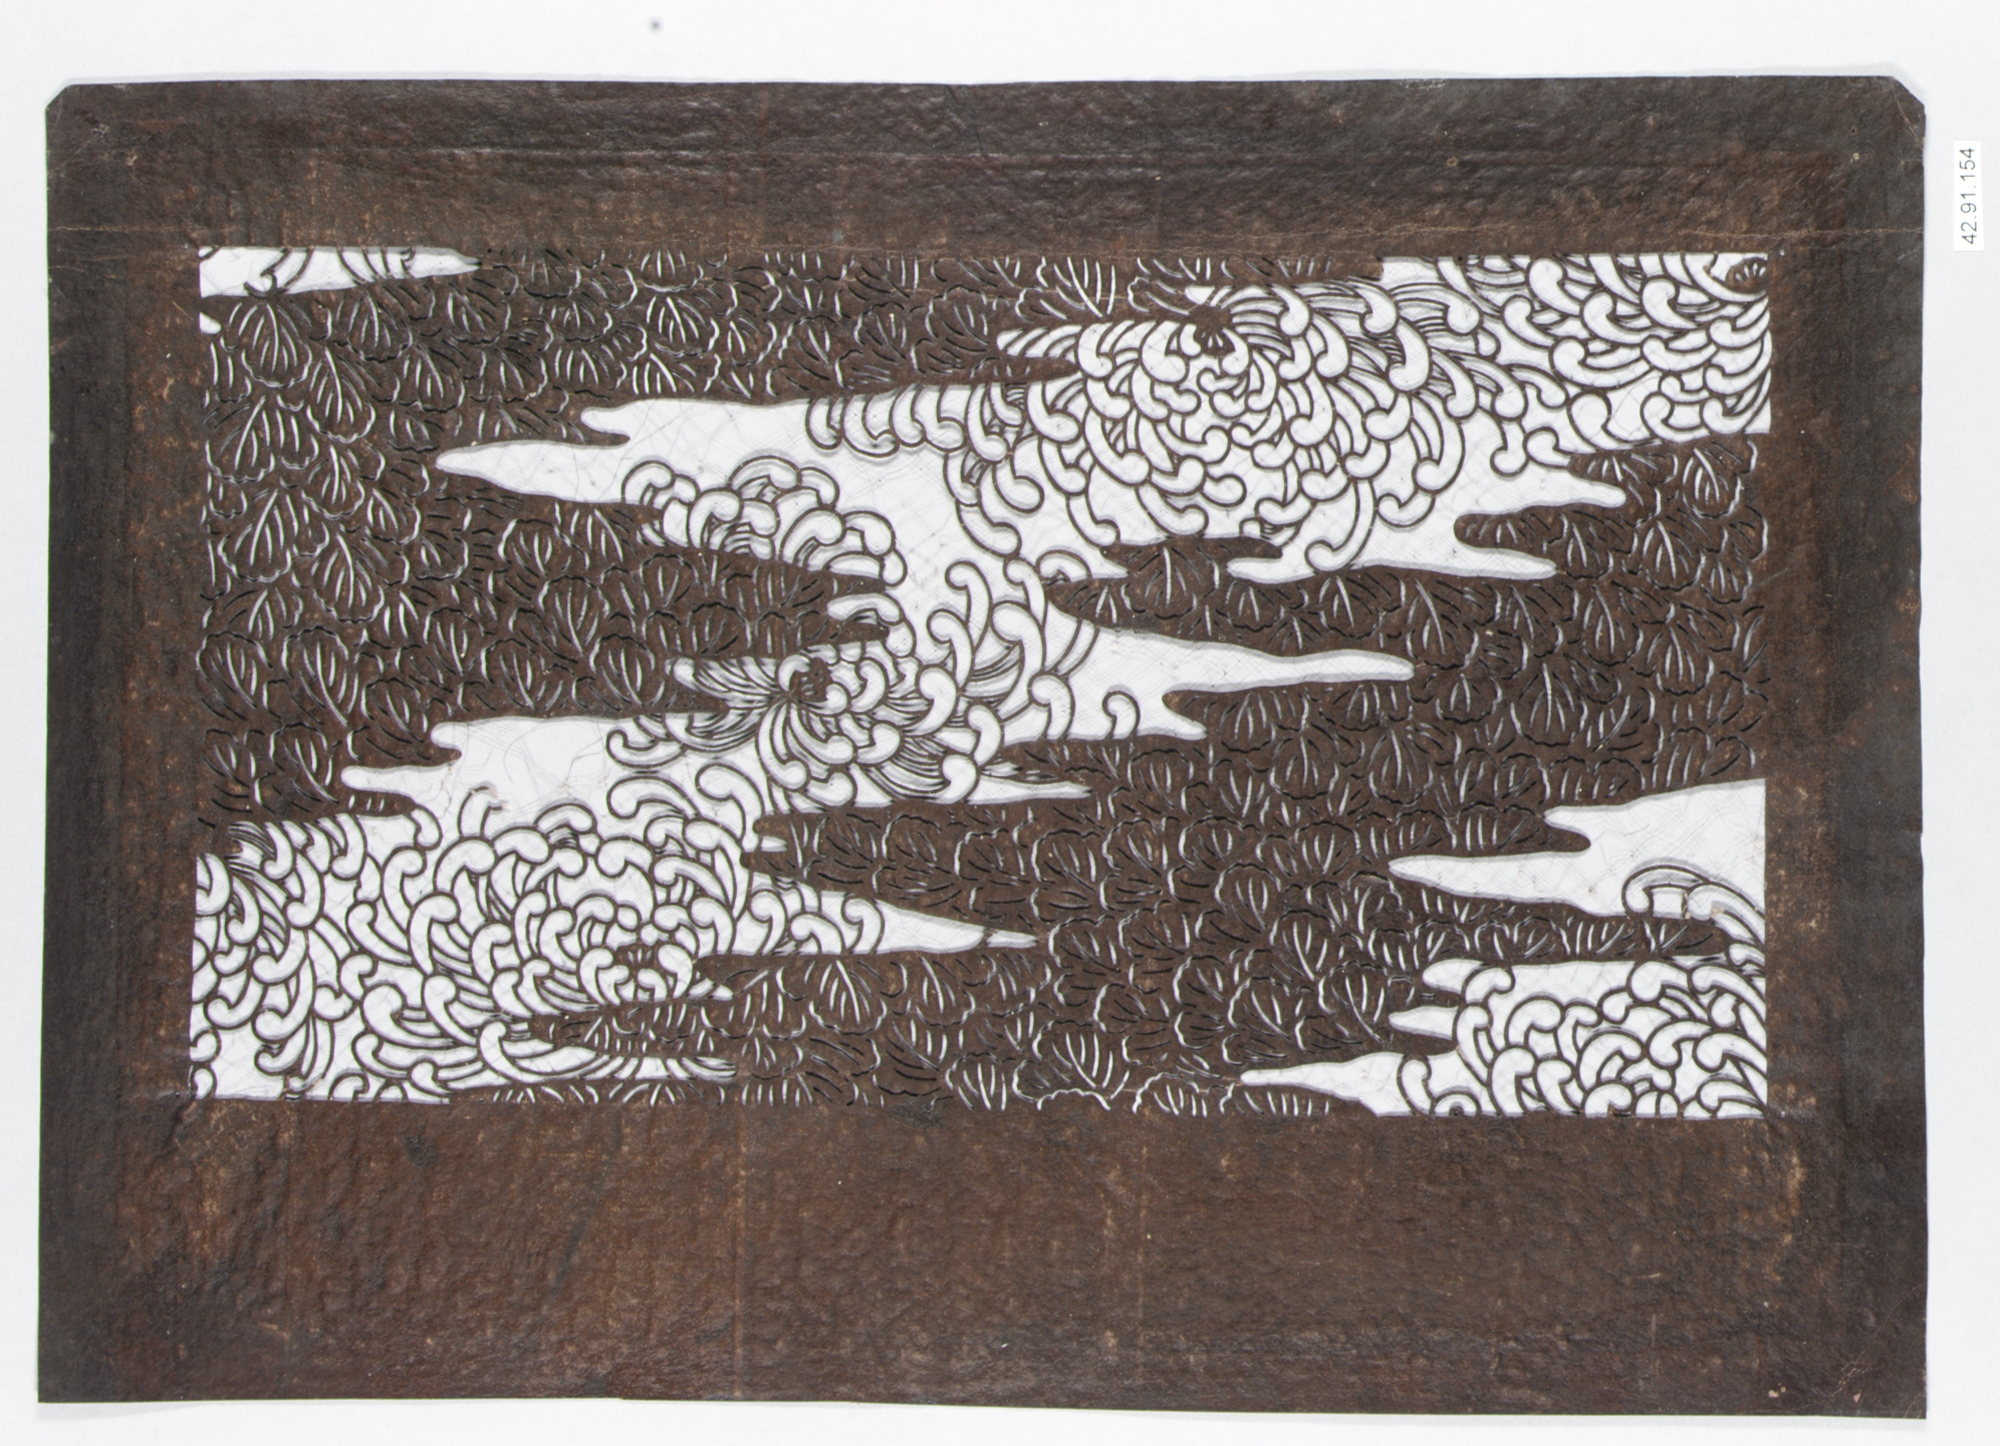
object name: stencil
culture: japanese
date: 1801-1900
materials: paper, silk